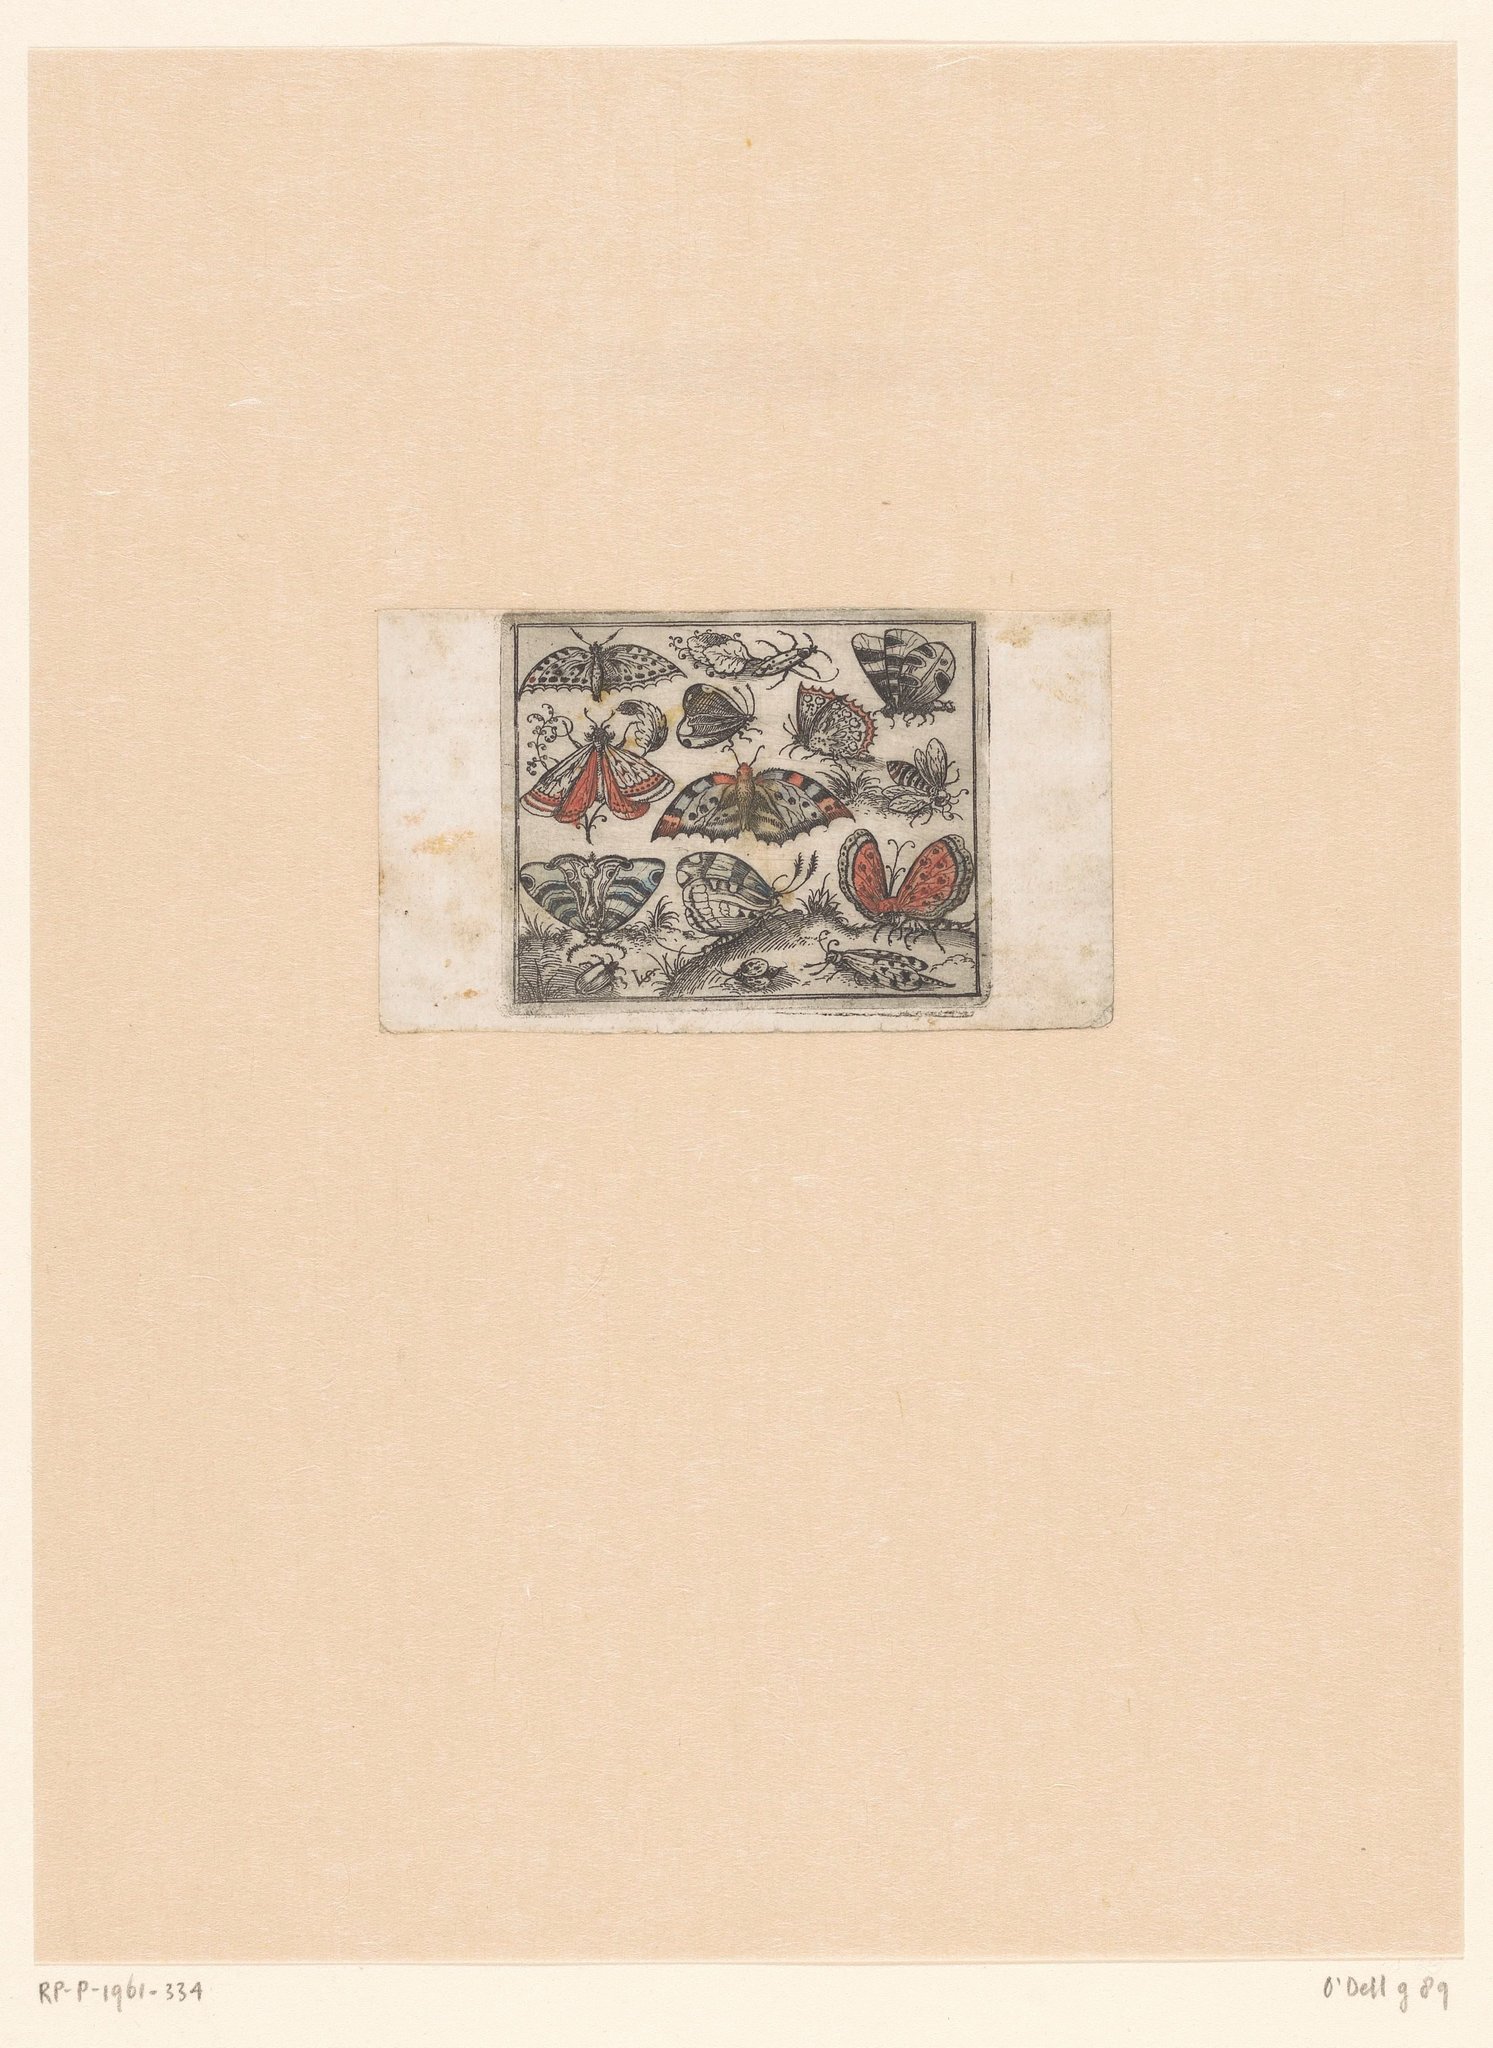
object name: print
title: Vlinders, kevers en een bij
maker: virgilius solis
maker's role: draughtsman, print maker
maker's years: 1514-1562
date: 1524-1562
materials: paper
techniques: engraving, etching, hand coloring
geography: nuremberg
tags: insects: bee, insects: butterfly, insects: beetle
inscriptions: collector's mark: Lugt 2228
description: Deze prent maakt deel uit van een serie bestaande uit een titelprent en negen prenten met samenstellingen van insecten, vogels en andere dieren.